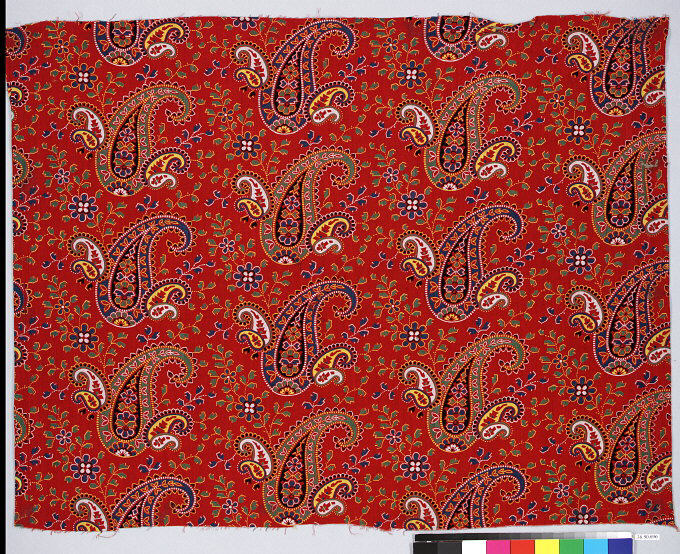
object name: piece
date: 1867-1900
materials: cotton